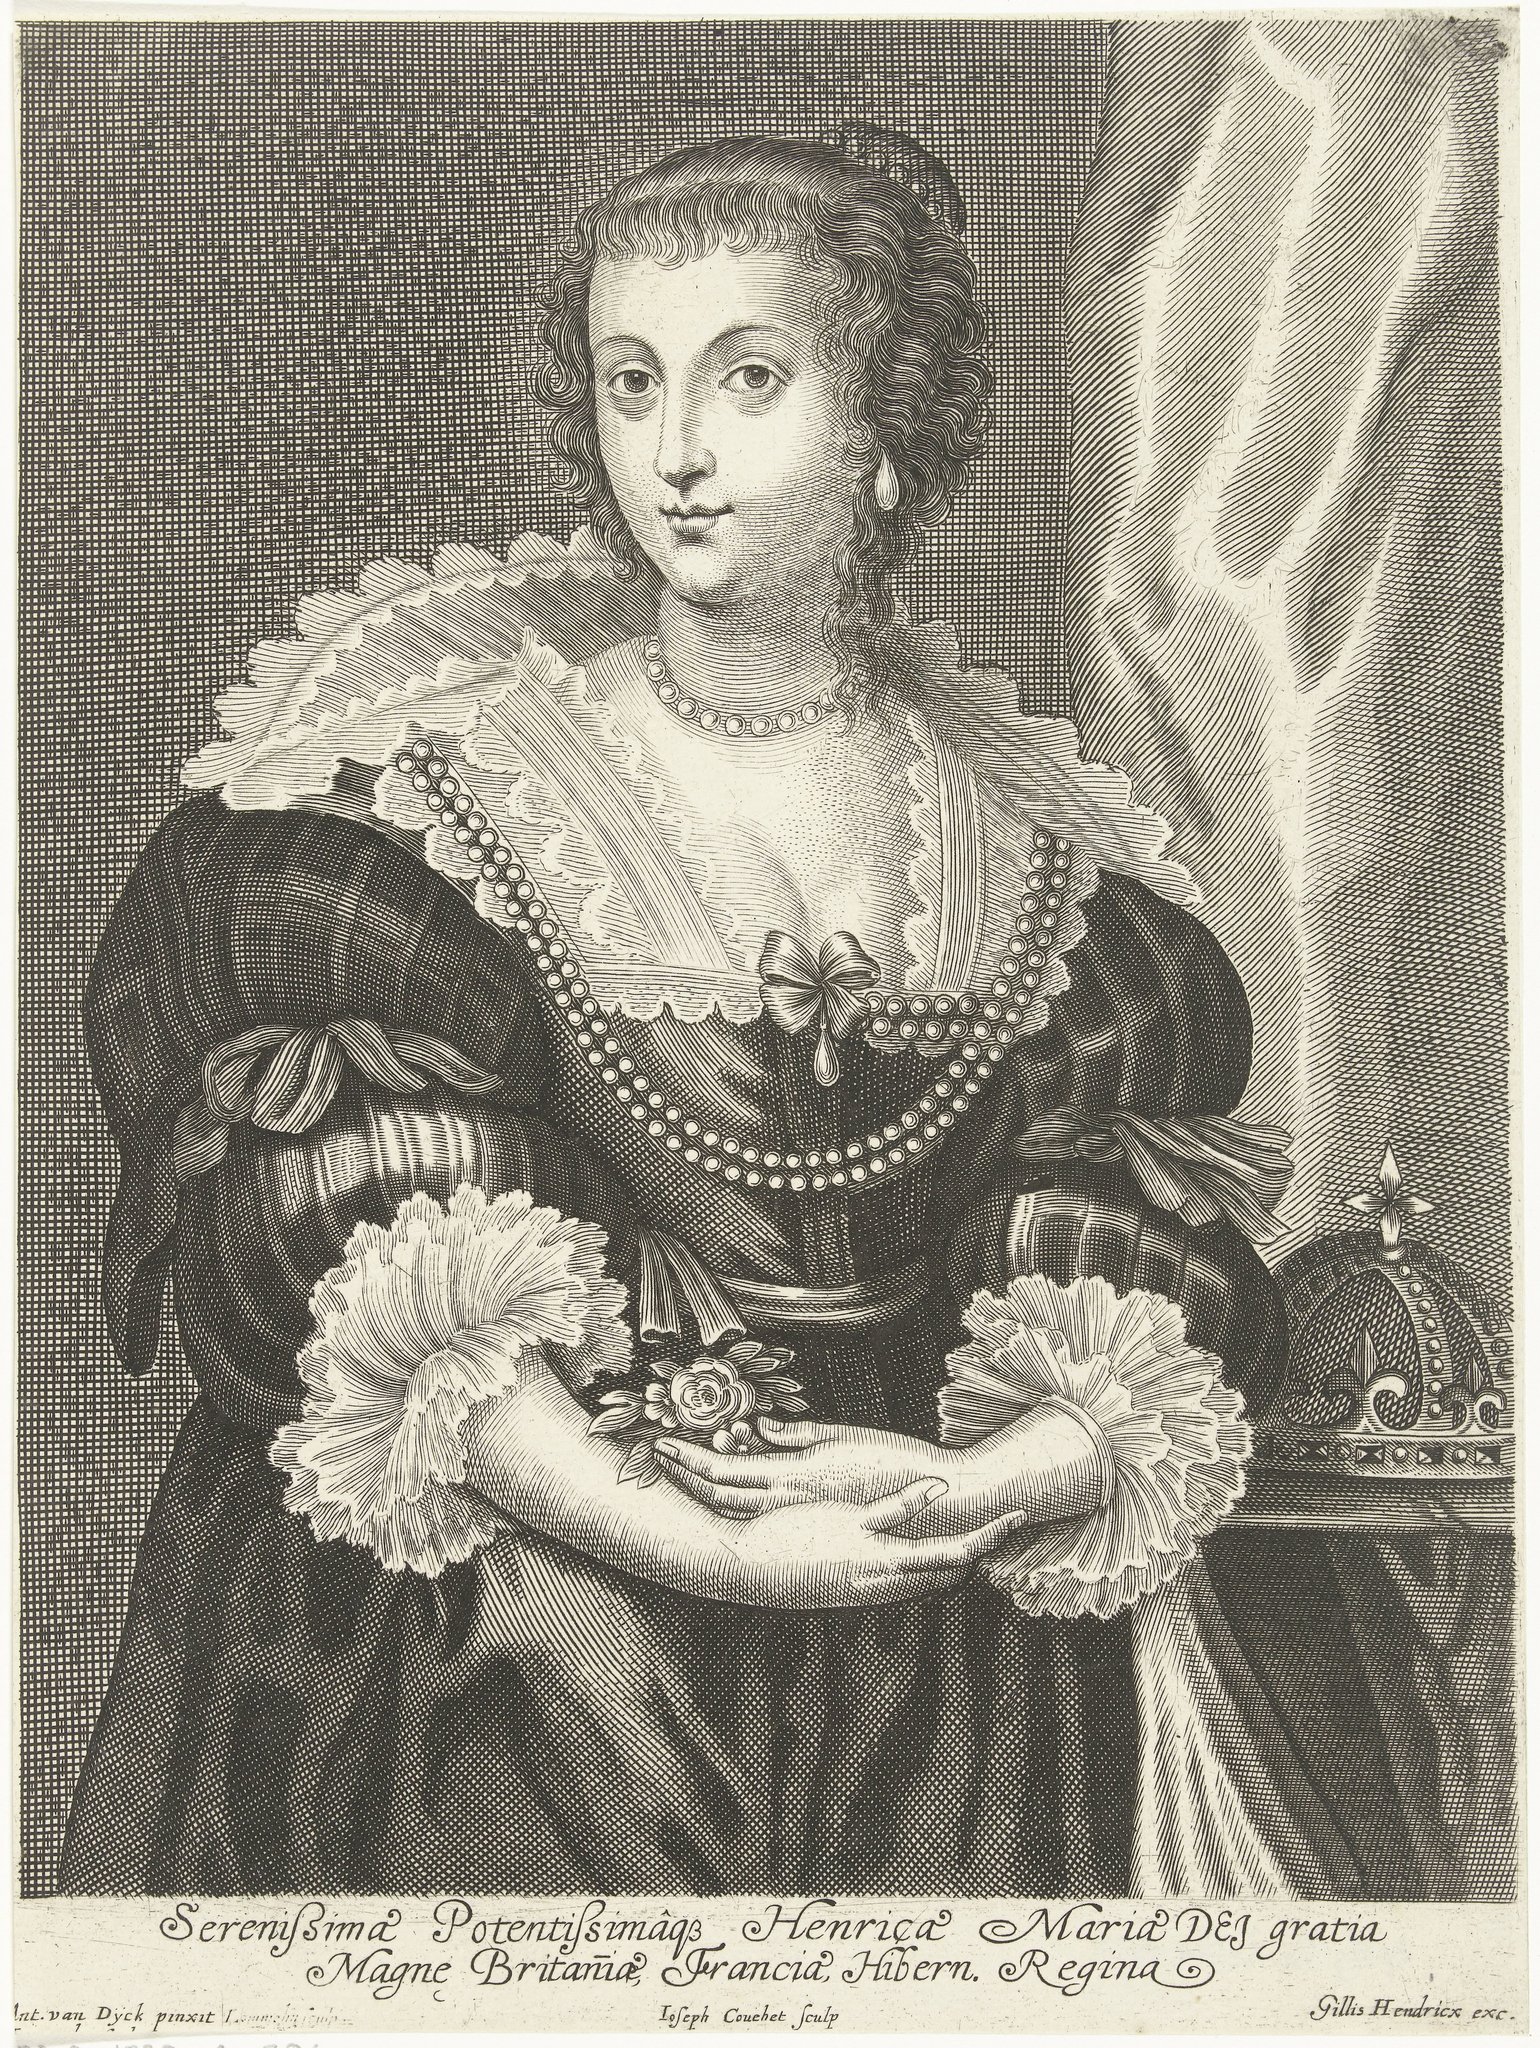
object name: print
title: Portret van Henrietta Maria, echtgenote van Karl I van Engeland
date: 1645-1678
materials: paper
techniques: engraving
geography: antwerp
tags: henriëtta maria van frankrijk (koningin van engeland, schotland en ierland)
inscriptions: collector's mark: Lugt 2228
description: Portret van Henrietta Maria: kniestuk, van voren gezien. Ze houdt een bloem in de hand. Naast haar op een tafeltje ligt haar kroon.